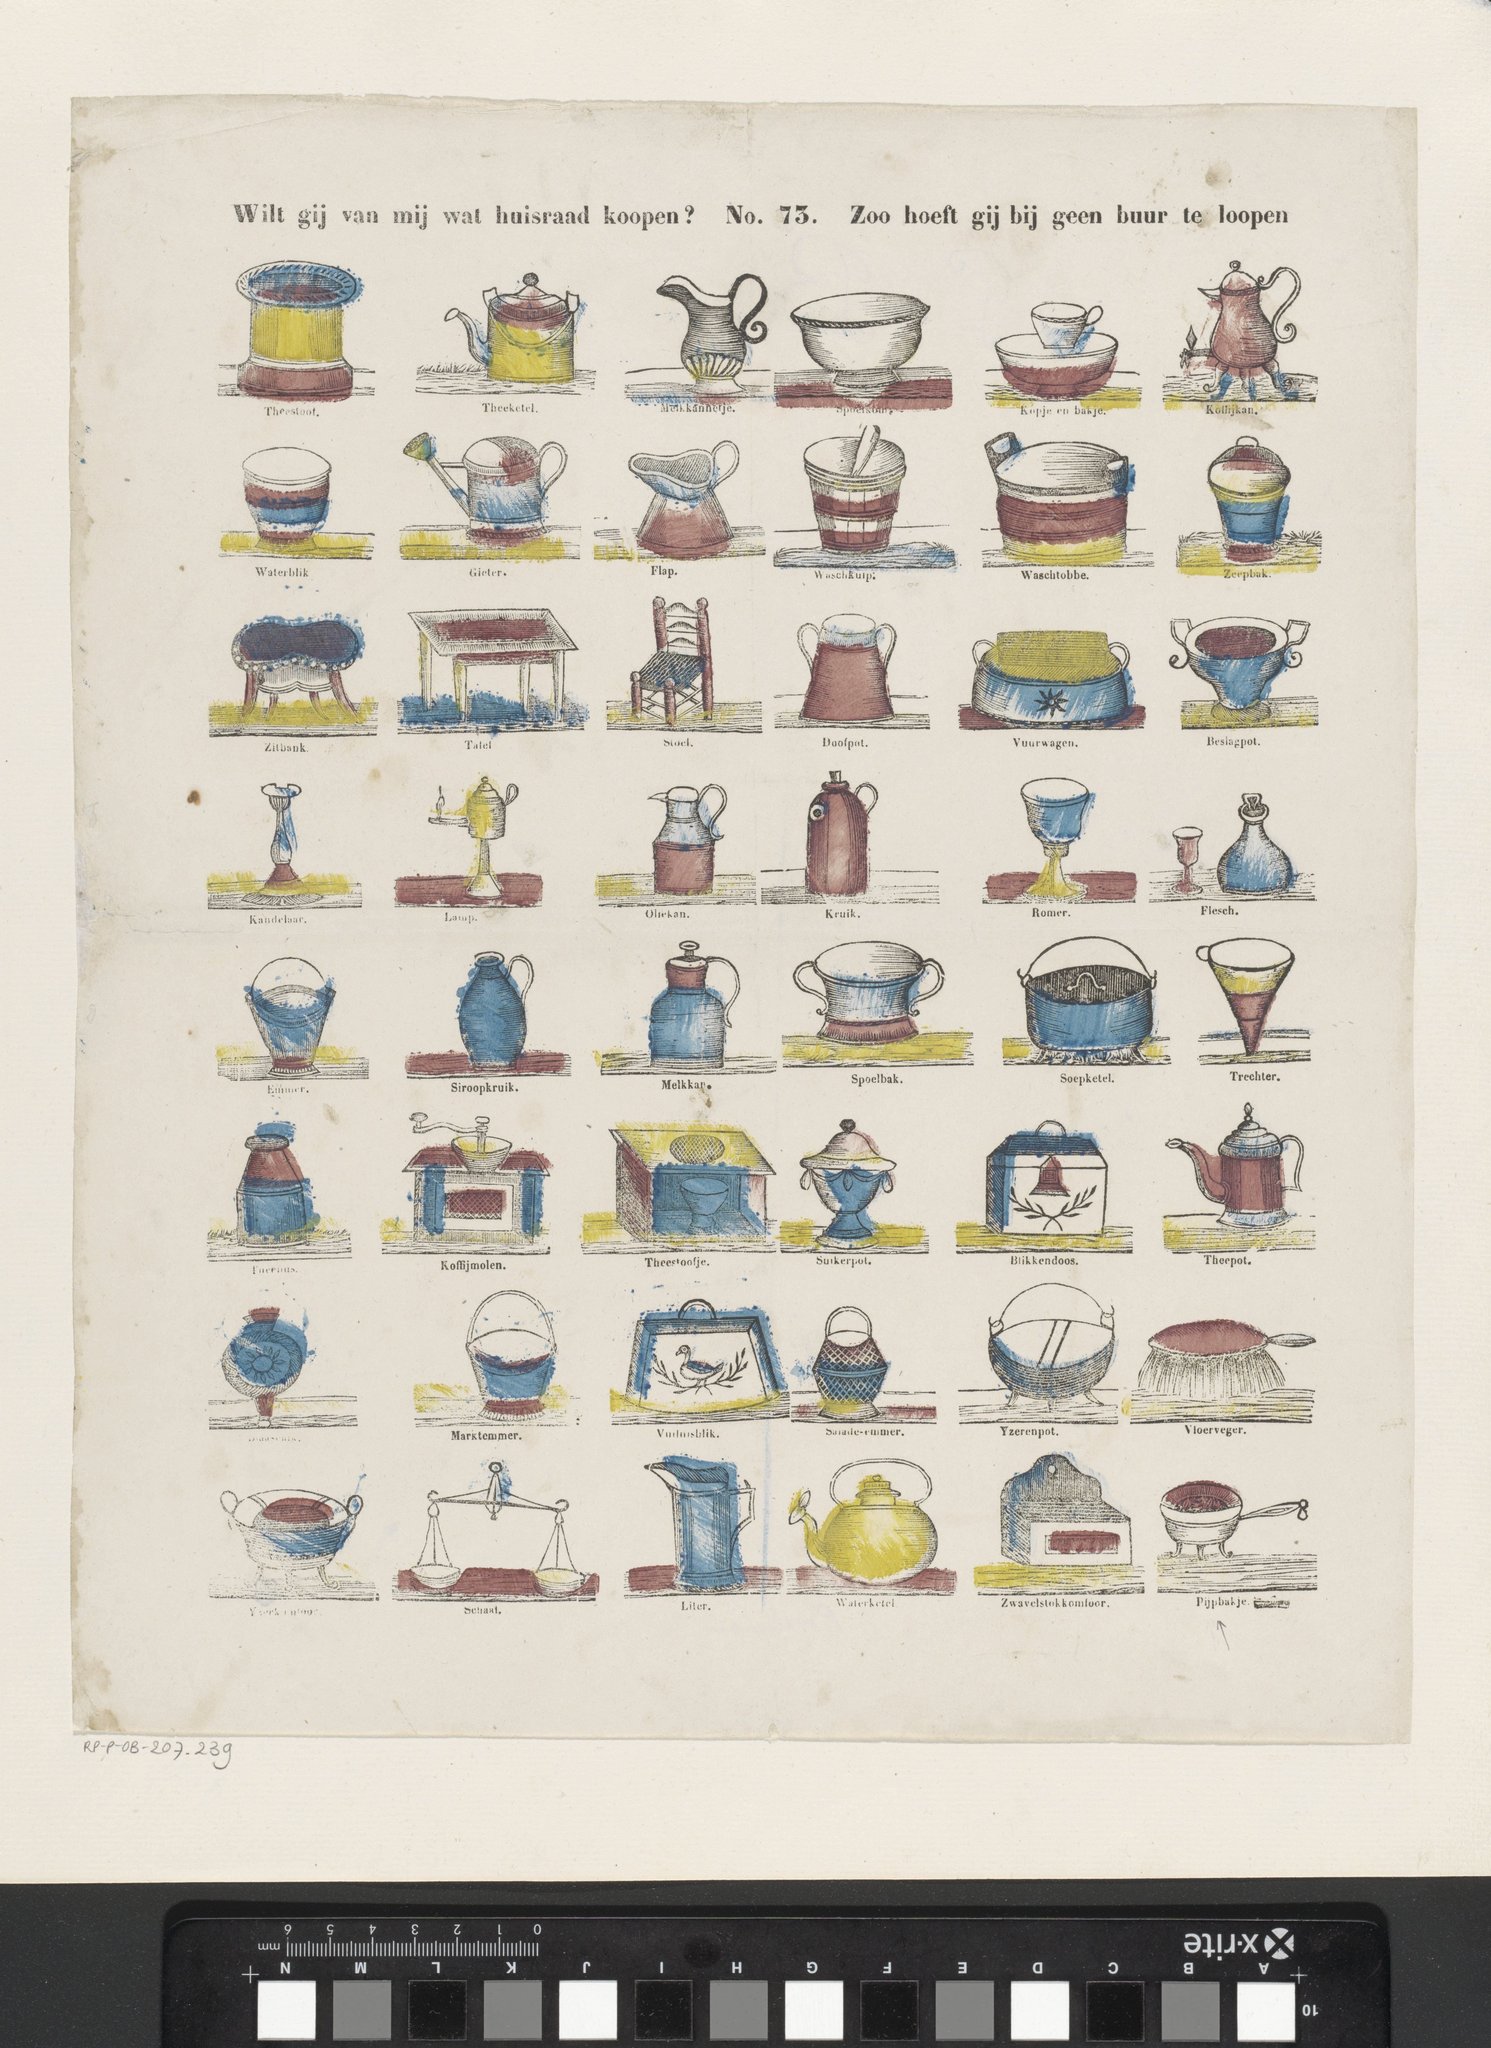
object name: popular print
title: Wilt gij van mij wat huisraad koopen? / Zoo hoeft gij bij geen buur te loopen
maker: Anonymous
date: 1848-1881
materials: paper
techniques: colour, letterpress printing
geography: netherlands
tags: (household) utensils and implements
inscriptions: collector's mark: Lugt 2760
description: Blad met 48 voorstellingen van huishoudelijke voorwerpen. Onder elke voorstelling een onderschrift. Genummerd midden boven: No. 73.